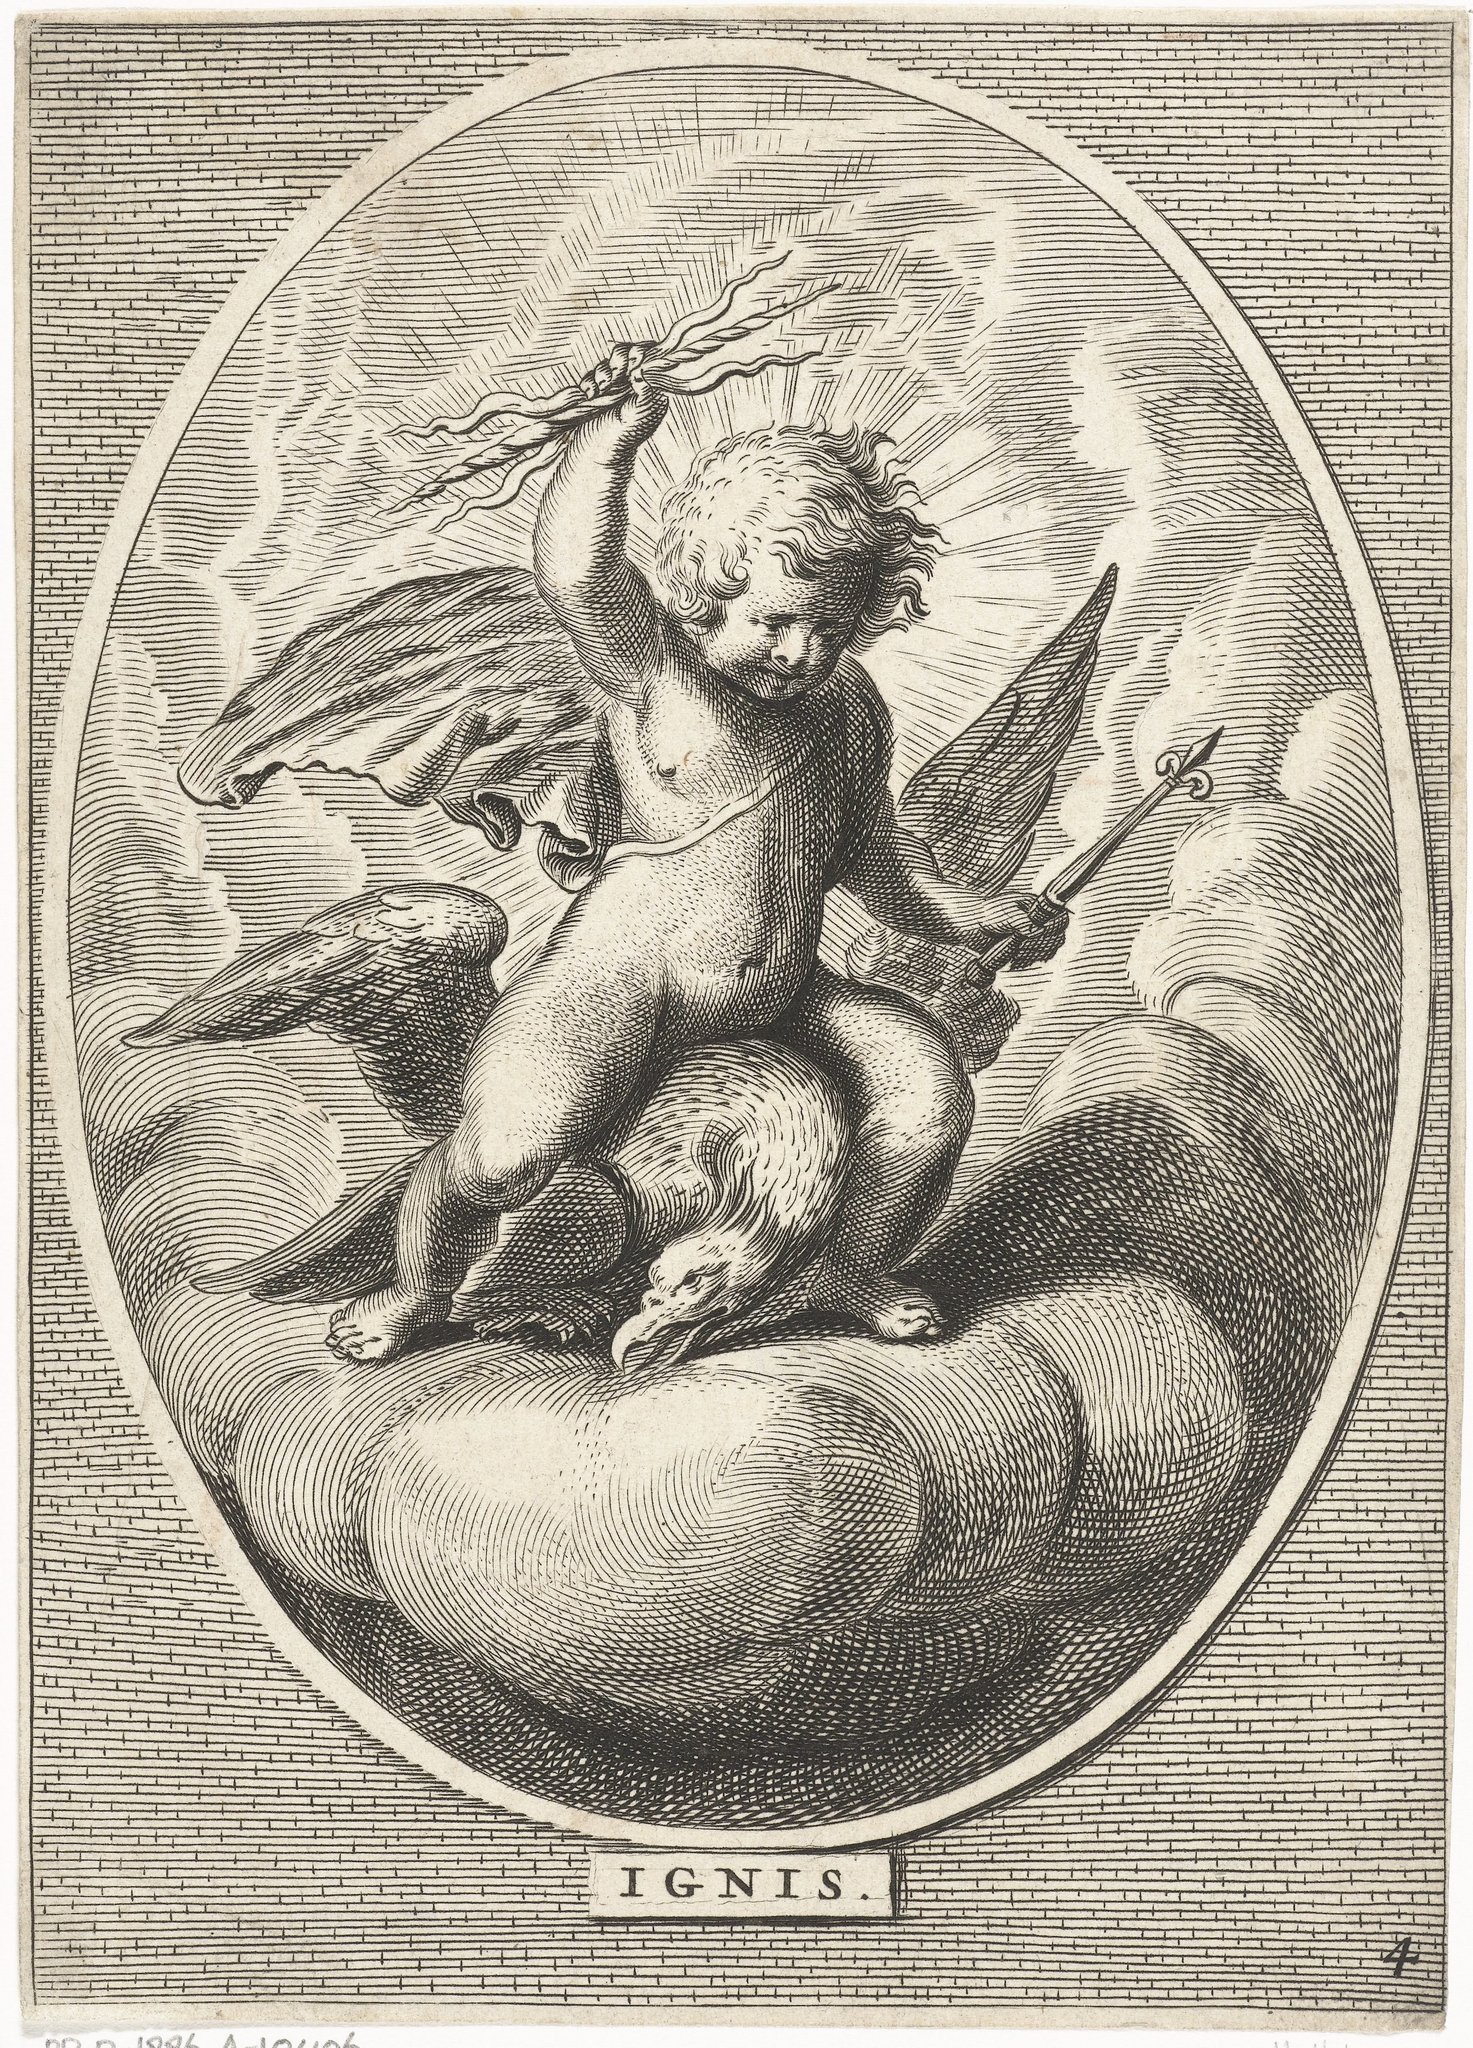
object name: print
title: Element vuur als kind met bliksemschichten op rug van adelaar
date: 1648-1706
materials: paper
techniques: engraving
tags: fire (one of the four elements), attributes of jupiter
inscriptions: collector's mark: Lugt 2228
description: Kopie naar prent van Cornelis van Dalen (II) uit serie van vier prenten met de vier elementen naar ontwerp van Abraham van Diepenbeeck.